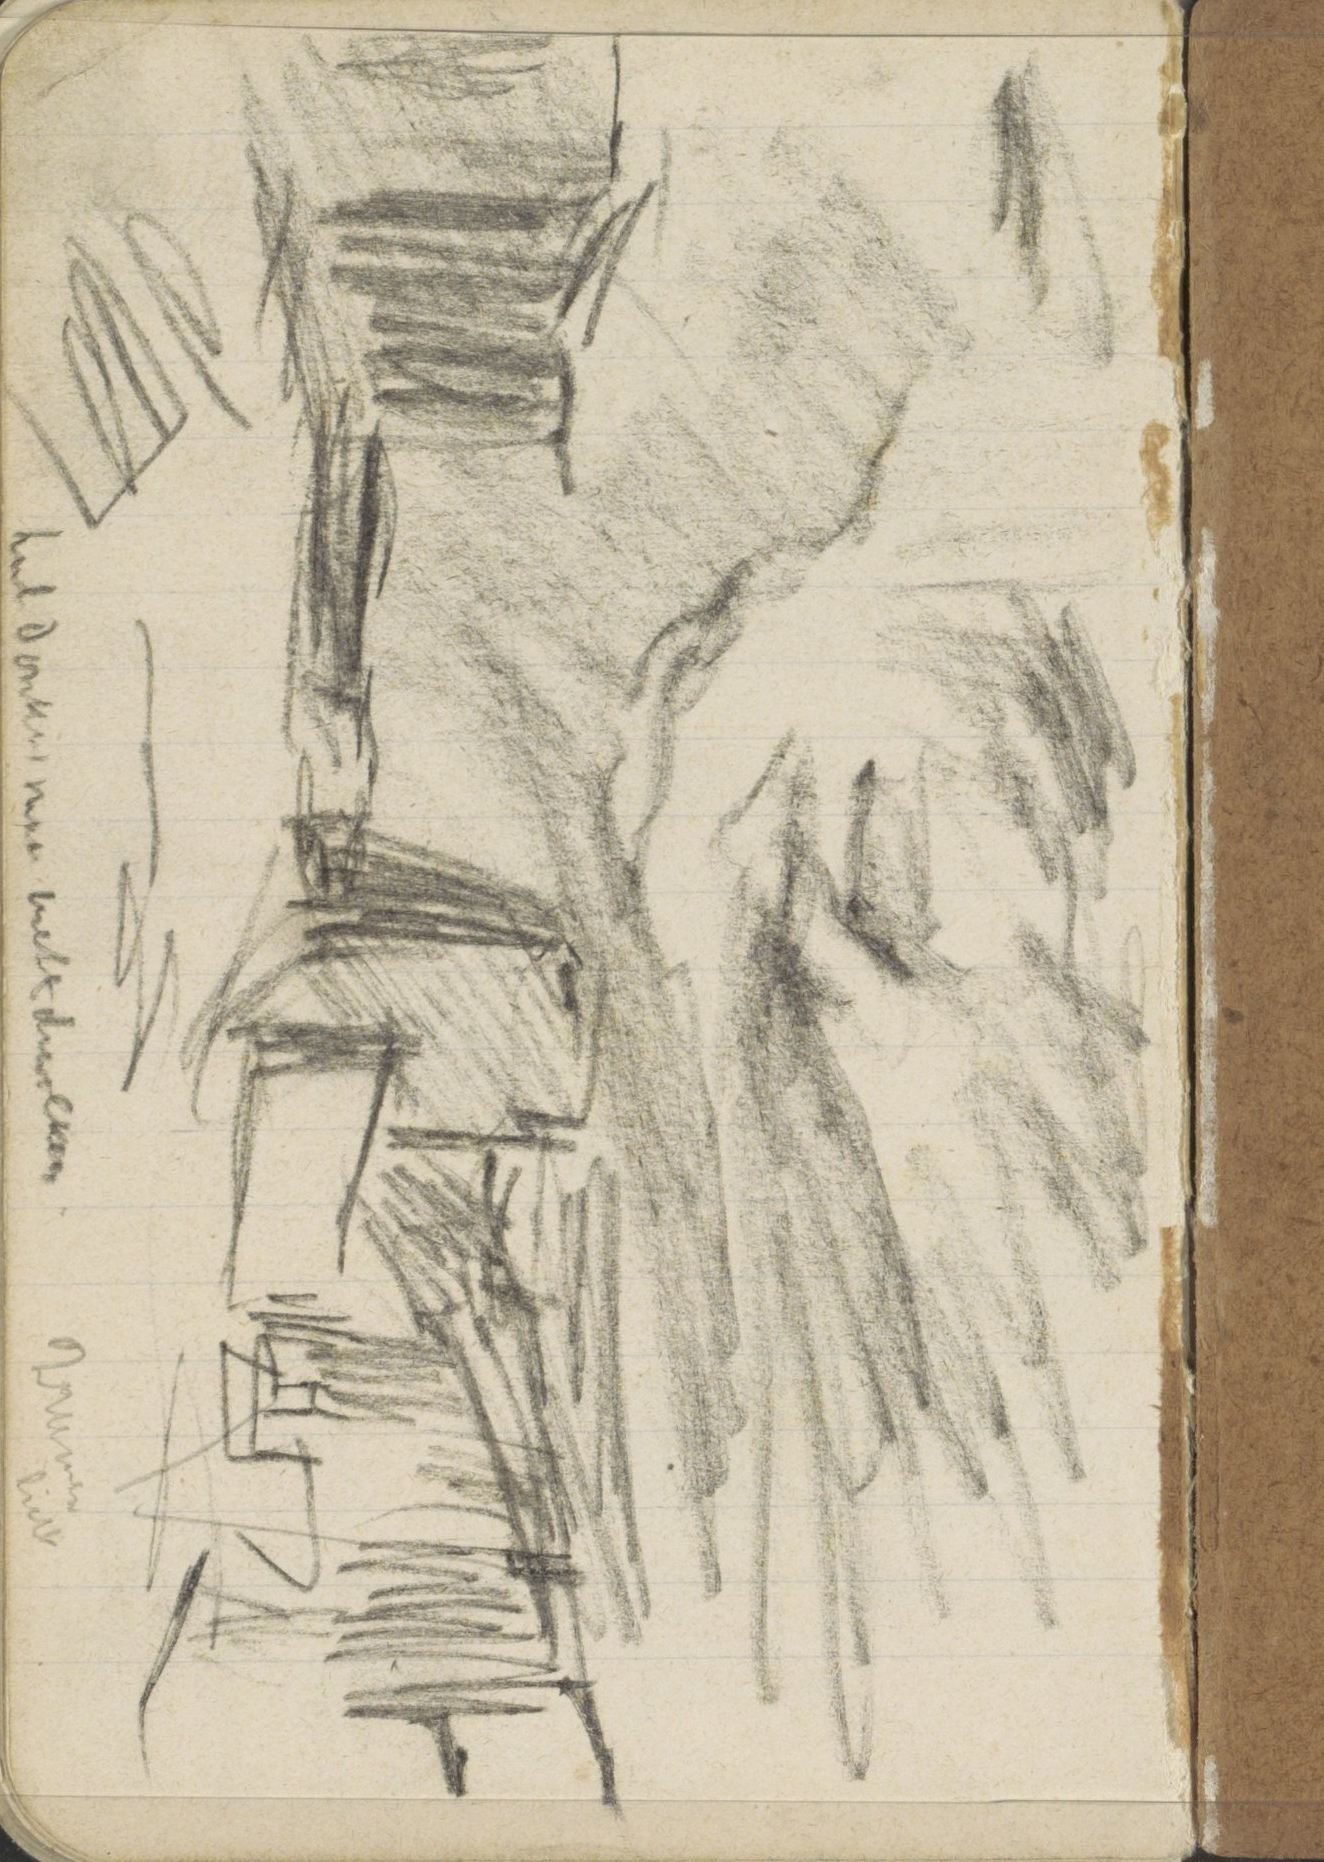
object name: sketchbook leaf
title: Gezicht in Amsterdam, mogelijk de Willemsstraat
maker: george hendrik breitner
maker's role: draughtsman, painter, print maker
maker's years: 1857-1923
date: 1882-1885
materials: chalk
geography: amsterdam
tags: civic architecture; edifices; dwellings, street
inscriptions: : ‘heel donker [...] wolken [...]’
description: Pagina 64 uit een schetsboek met 34 bladen.